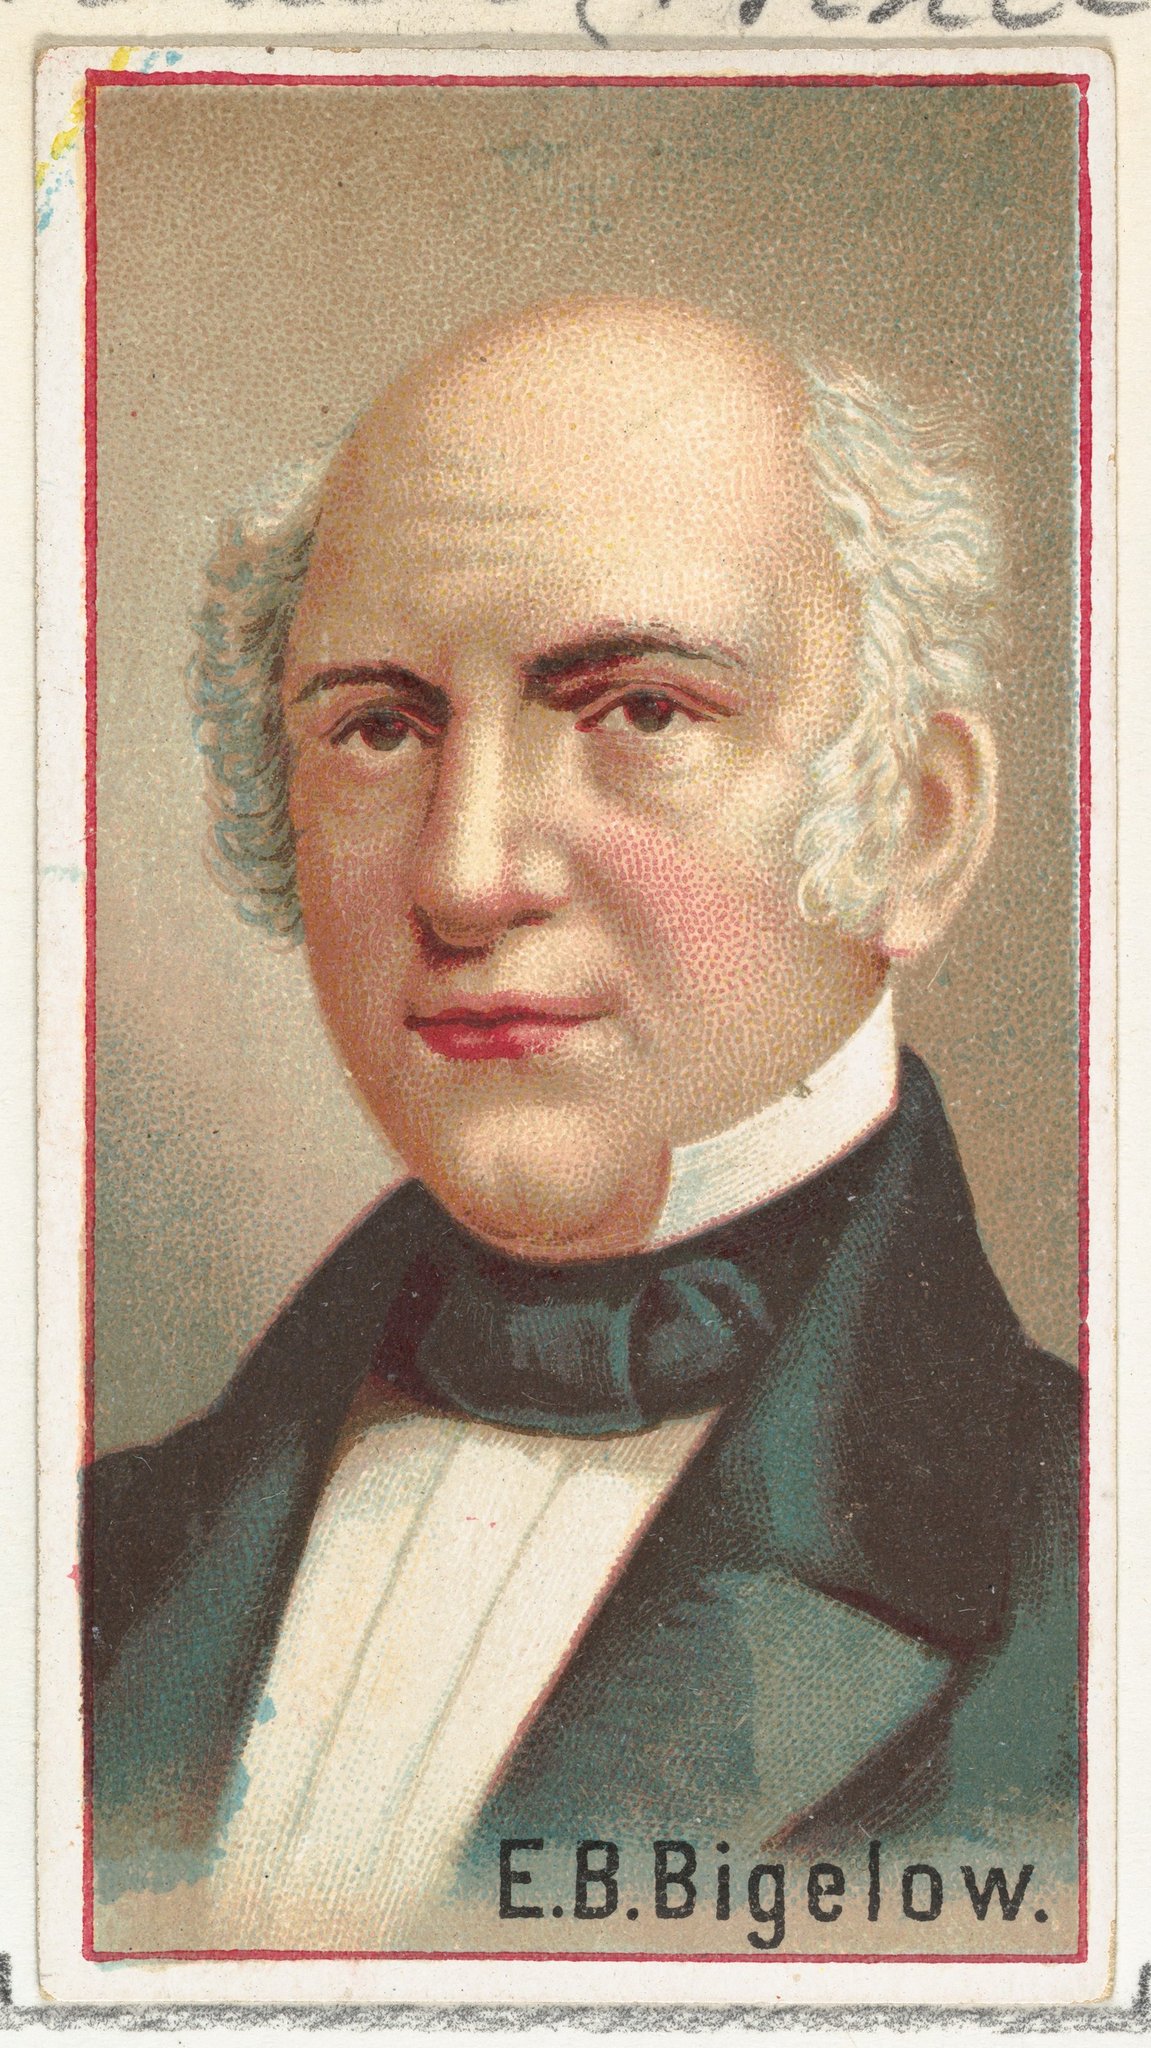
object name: print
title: E. B. Bigelow, printer's sample for the World's Inventors souvenir album (A25) for Allen & Ginter Cigarettes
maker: allen & ginter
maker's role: publisher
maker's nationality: american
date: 1888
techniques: color lithograph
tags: men,portraits